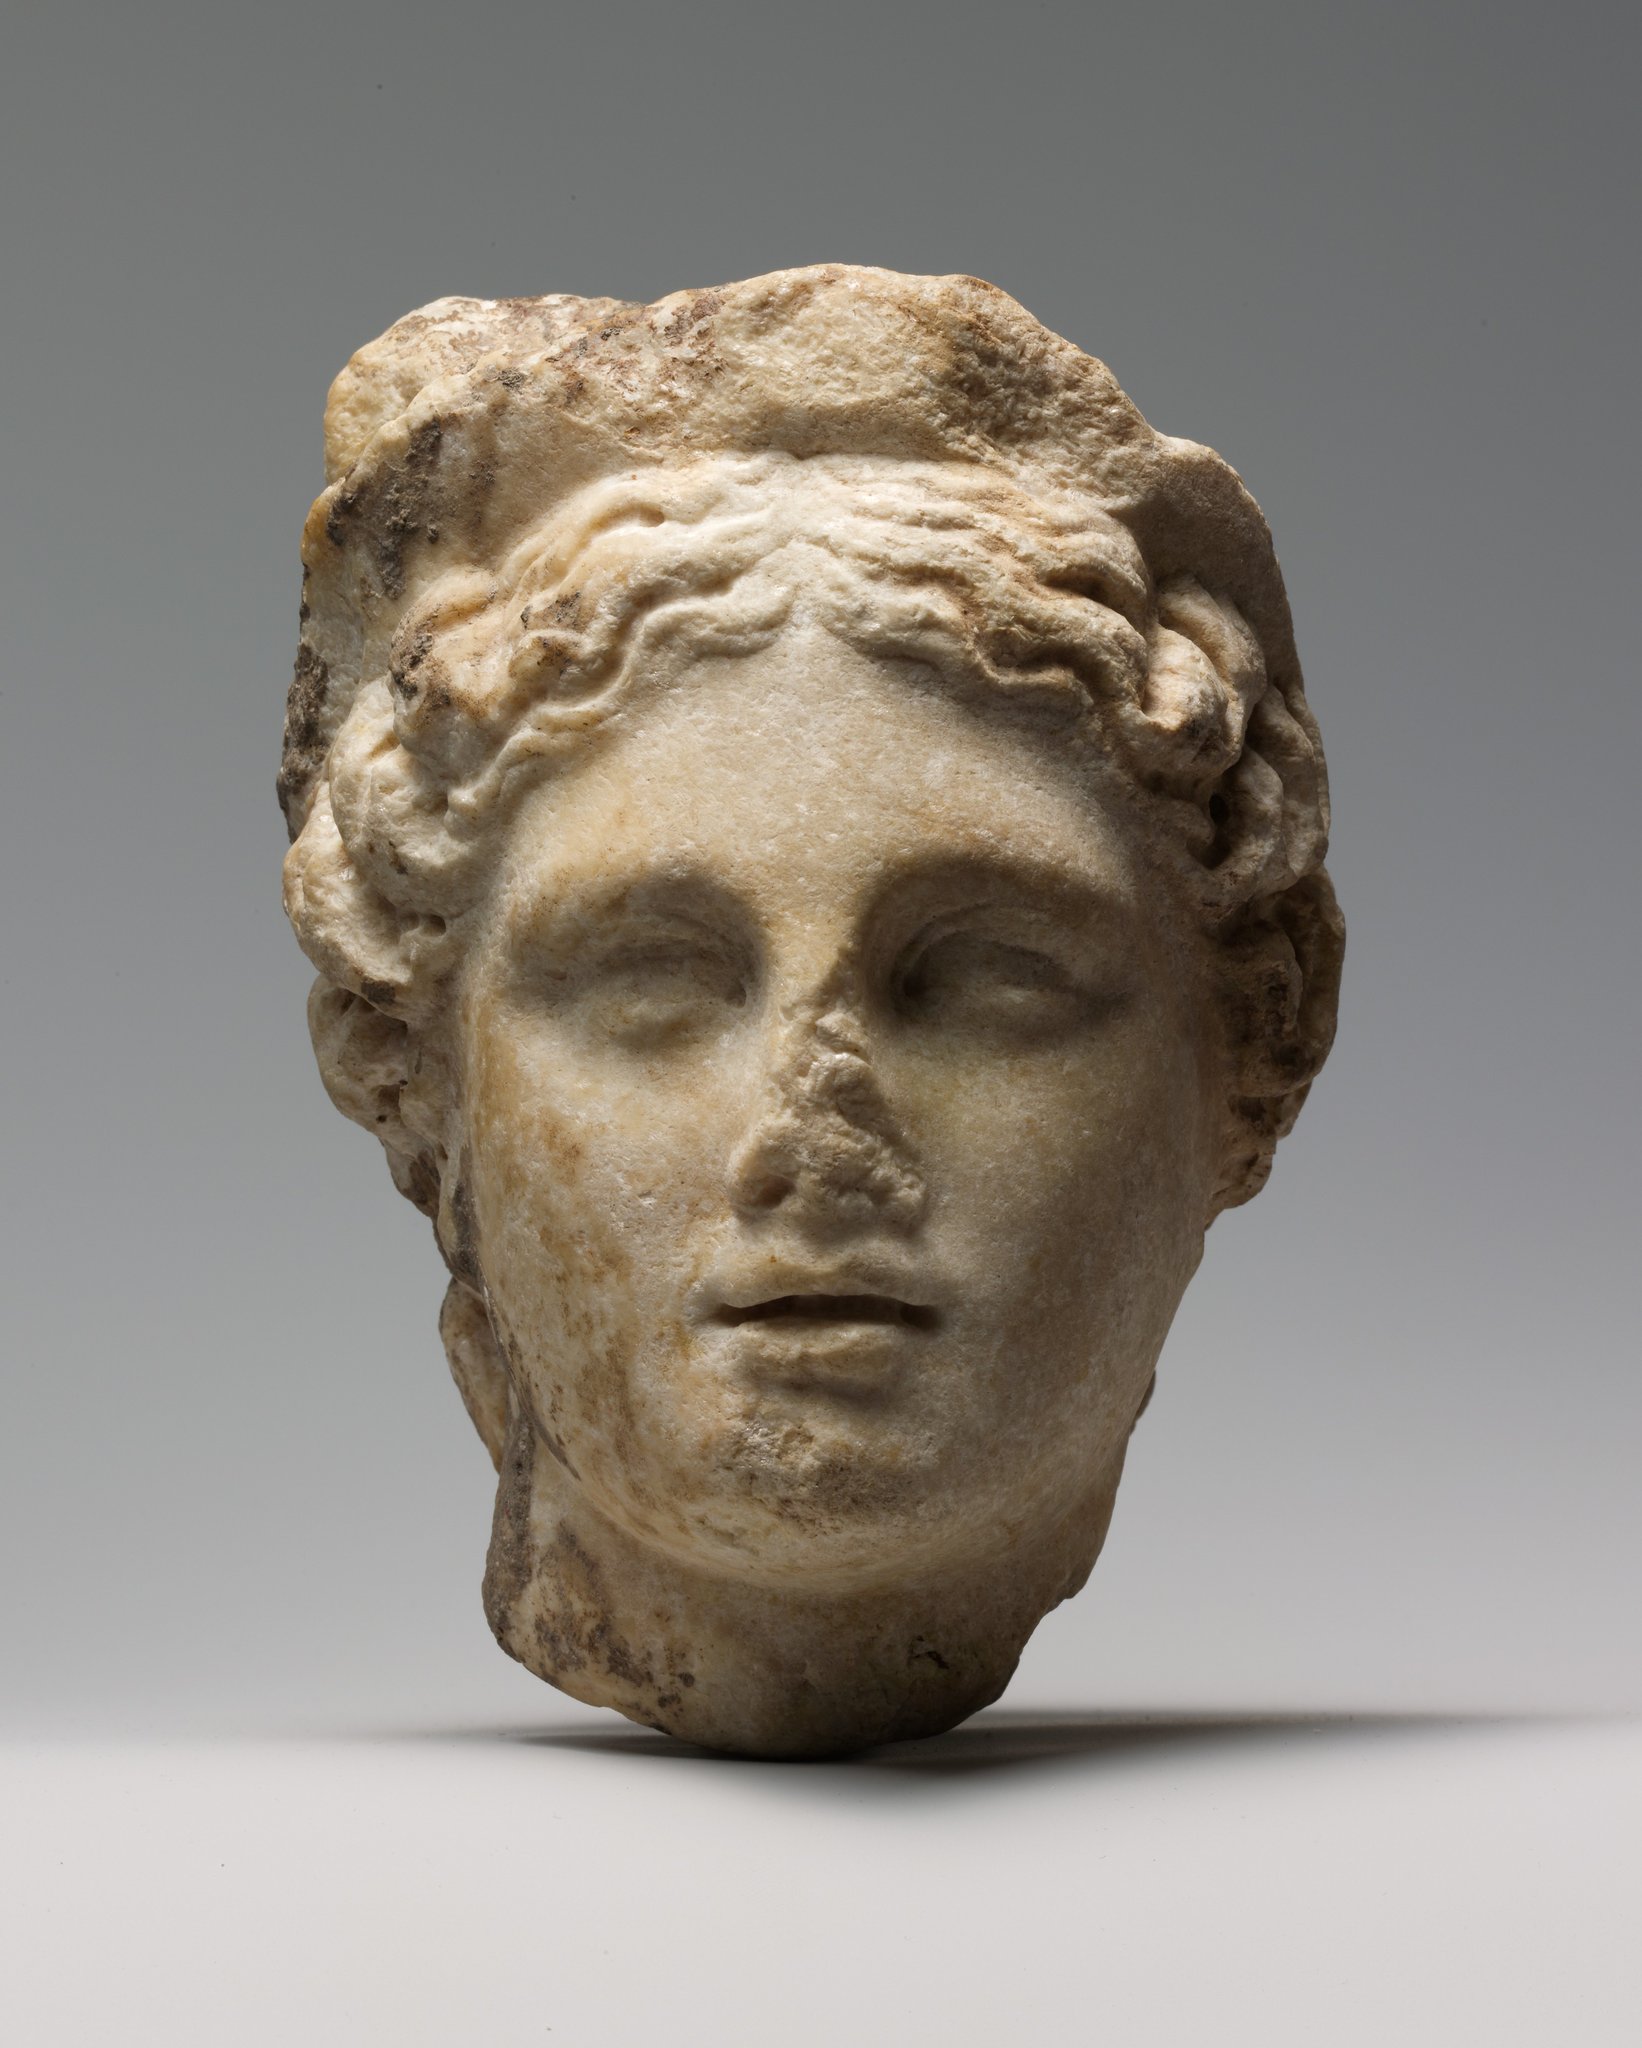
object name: head of a woman wearing diadem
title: Marble head of a woman wearing a diadem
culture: roman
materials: marble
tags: diadems,heads,women